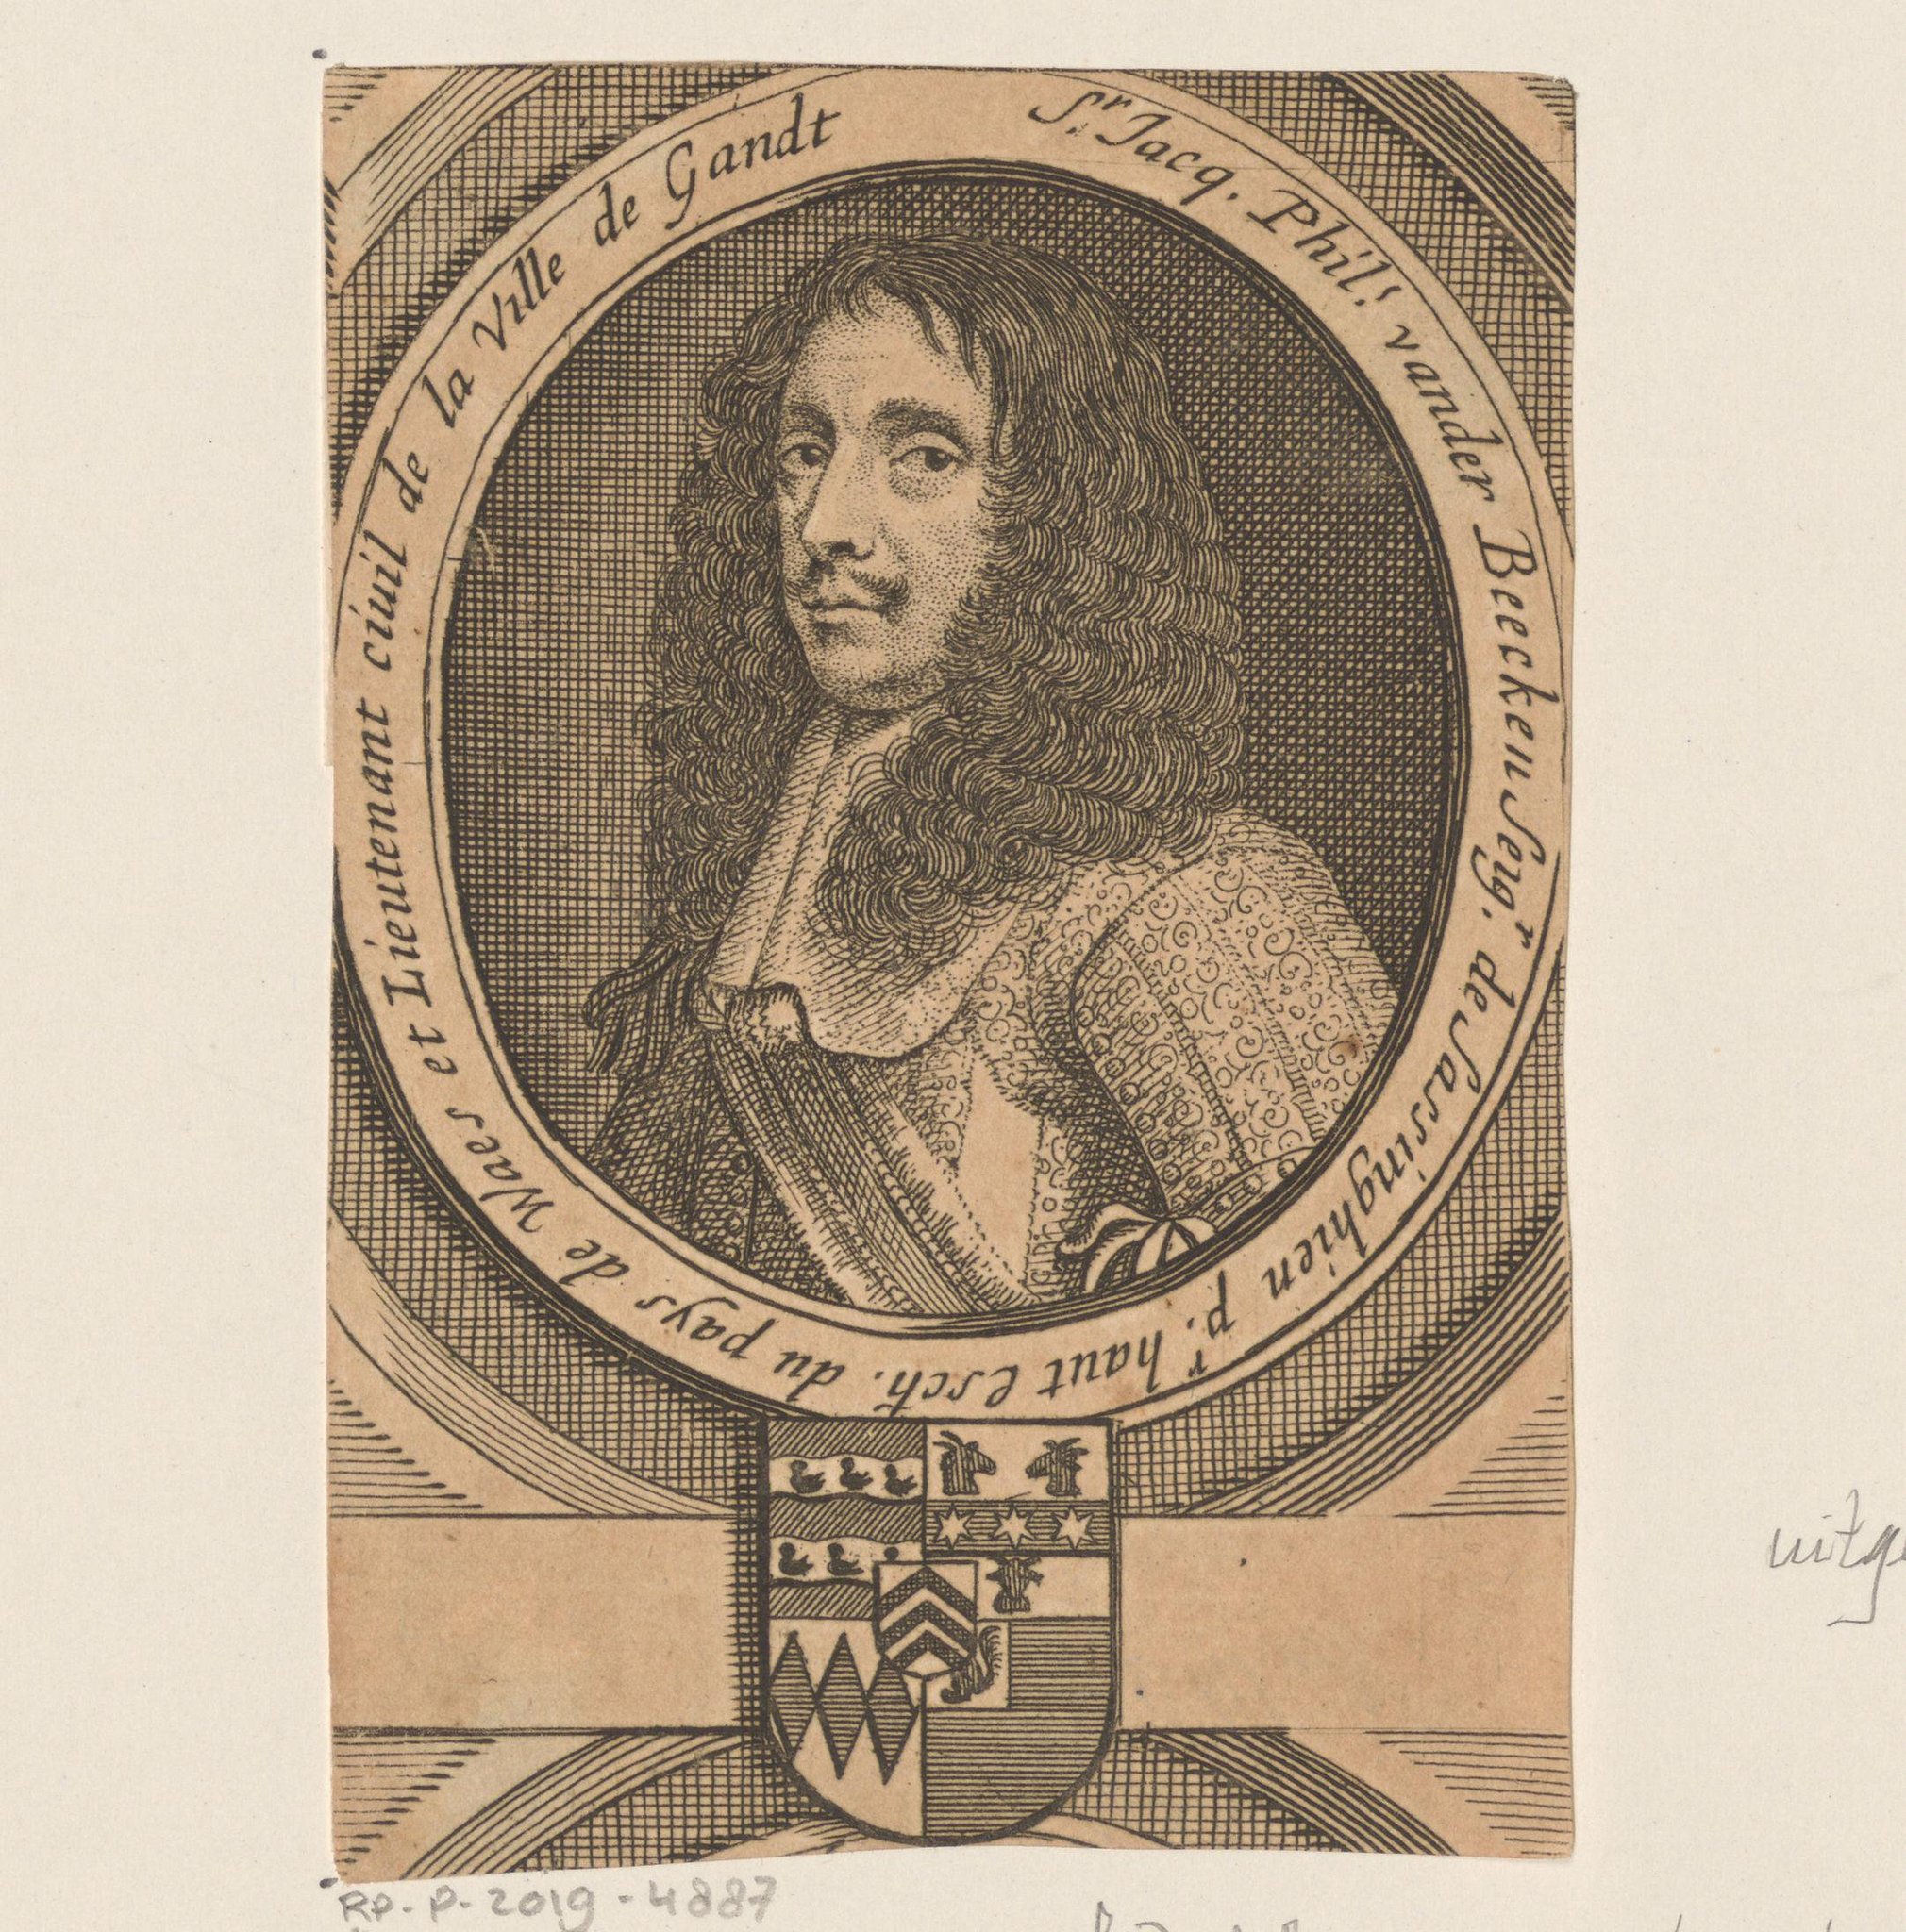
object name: print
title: Portret van Jacques Philippe van der Beecken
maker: Anonymous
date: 1650-1749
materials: paper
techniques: engraving, etching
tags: historical persons, armorial bearing, heraldry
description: Met midden onder zijn wapenschild, mogelijk onjuist.